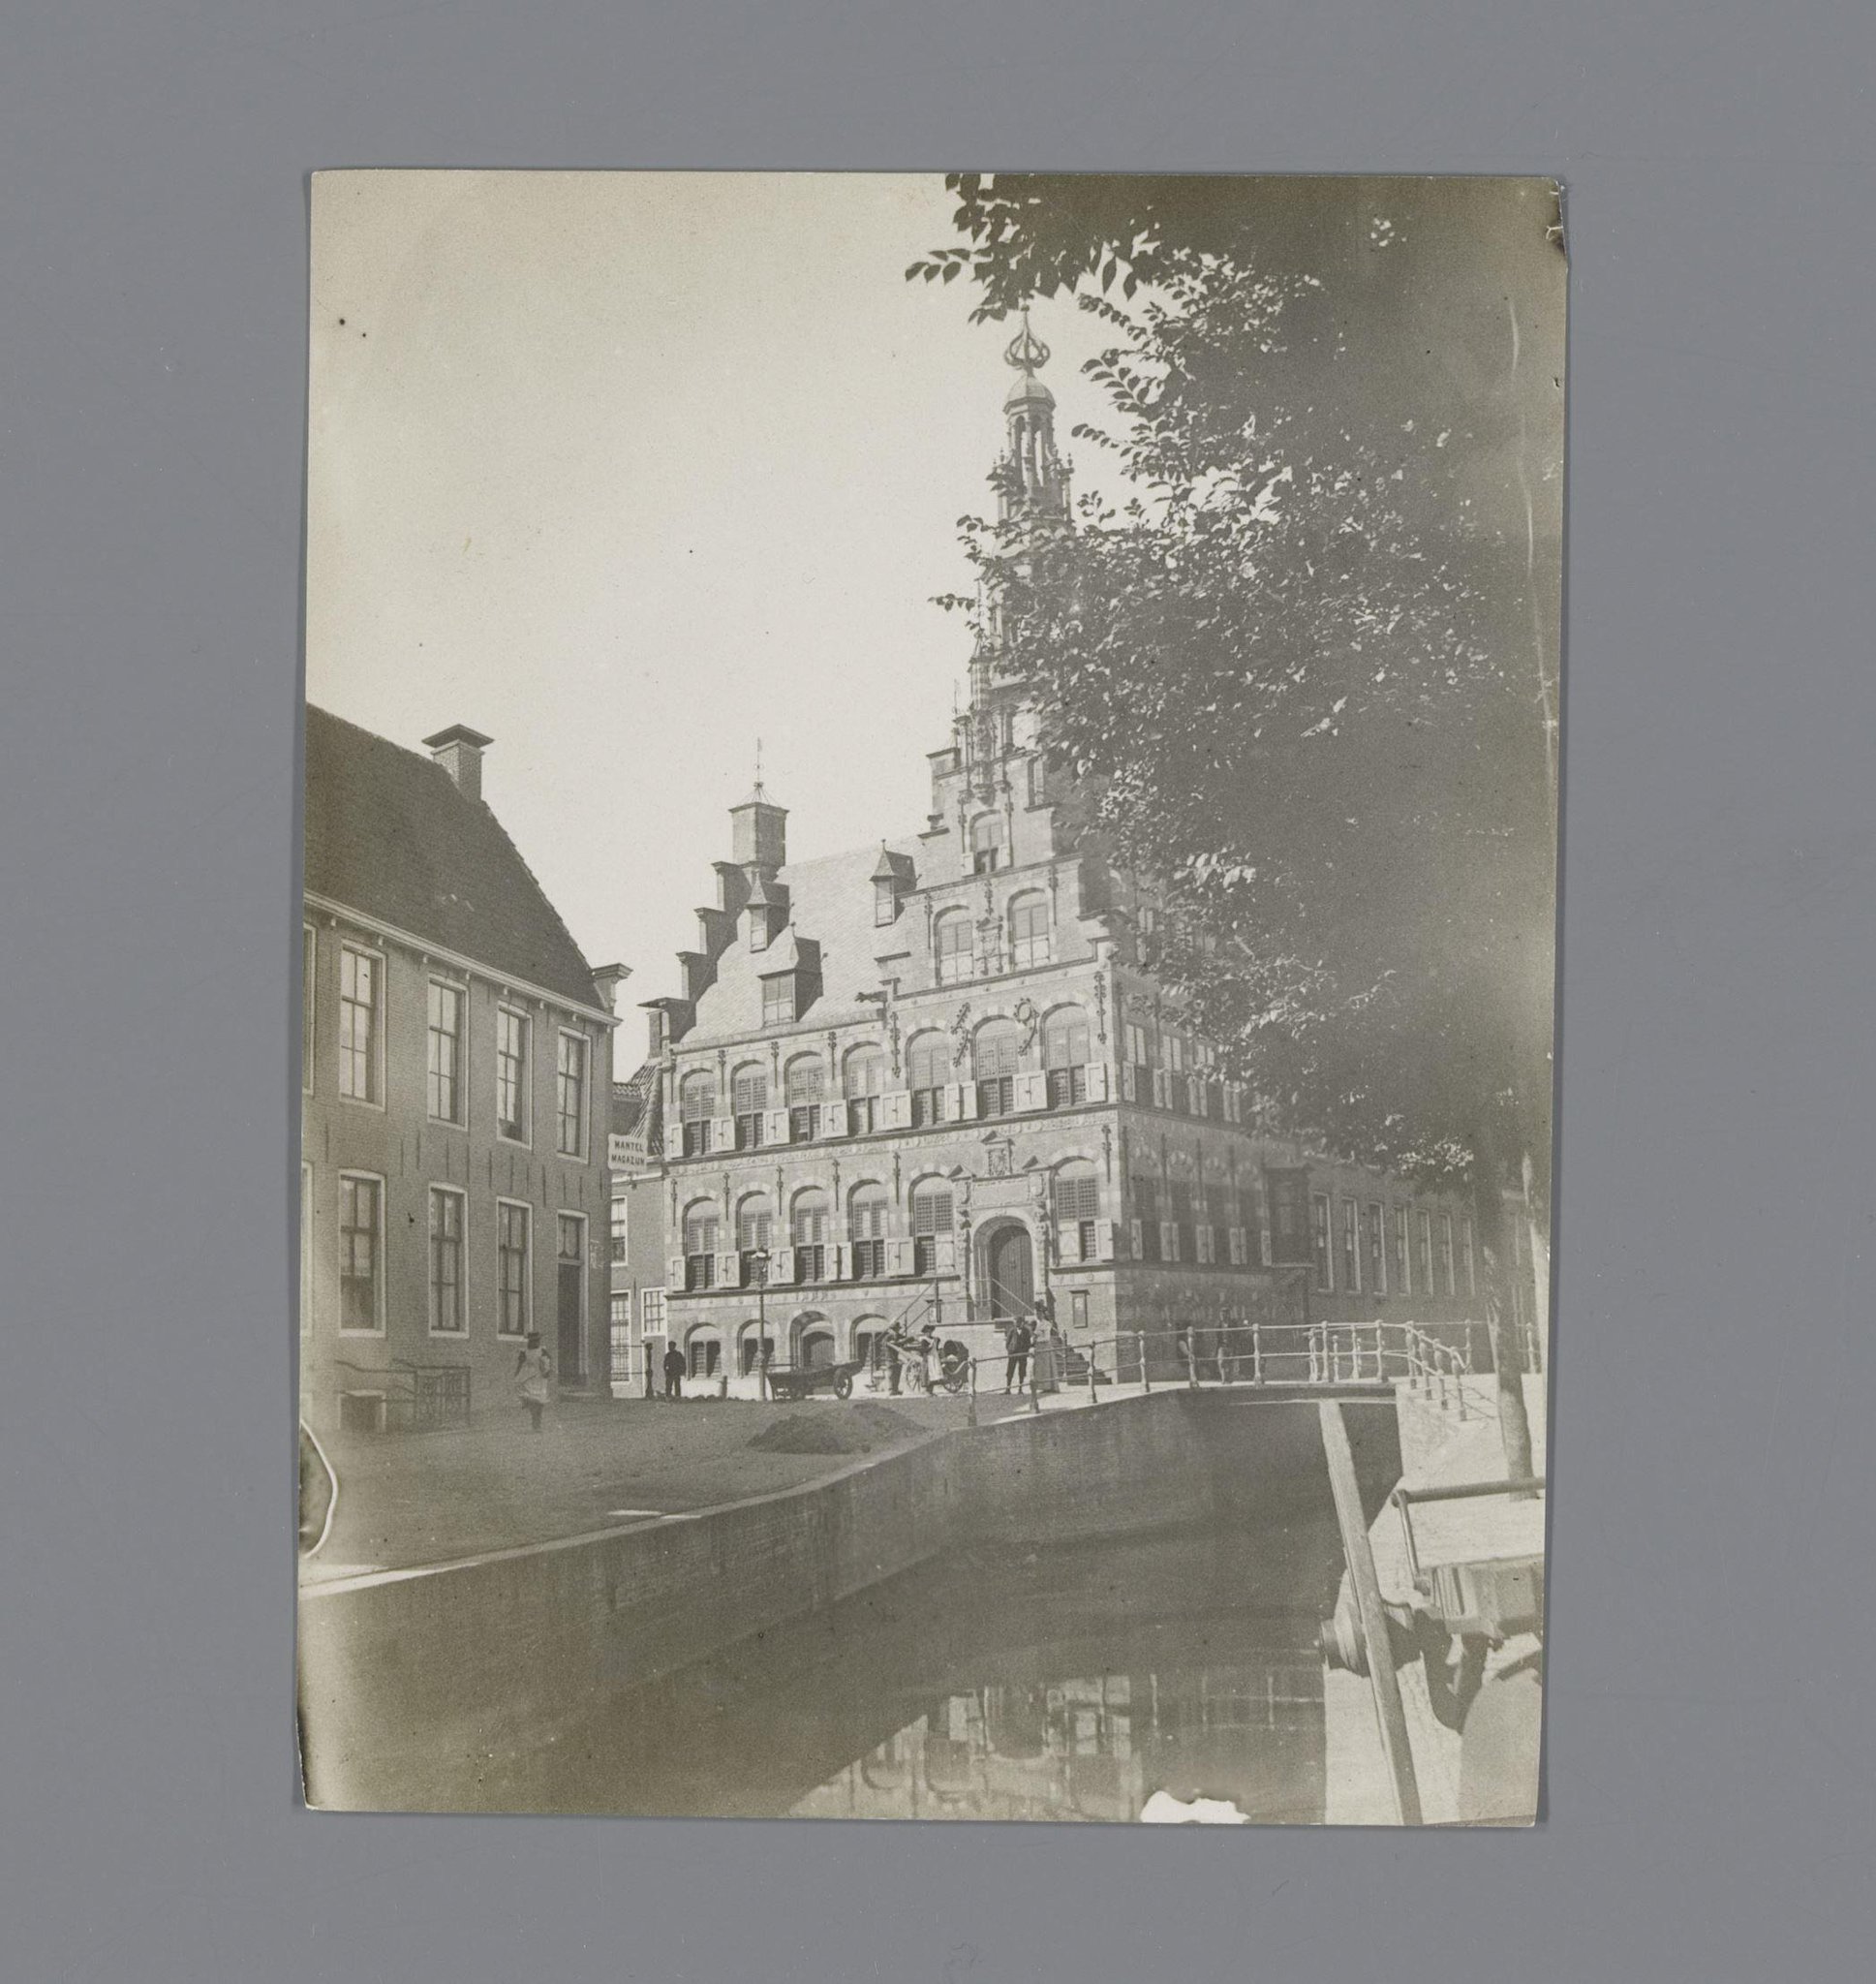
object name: photograph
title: Gezicht op het stadhuis te Franeker, Friesland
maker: Anonymous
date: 1900-1930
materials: photographic support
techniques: gelatin silver print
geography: franeker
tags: townhall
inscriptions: annotation: ‘Franeker’